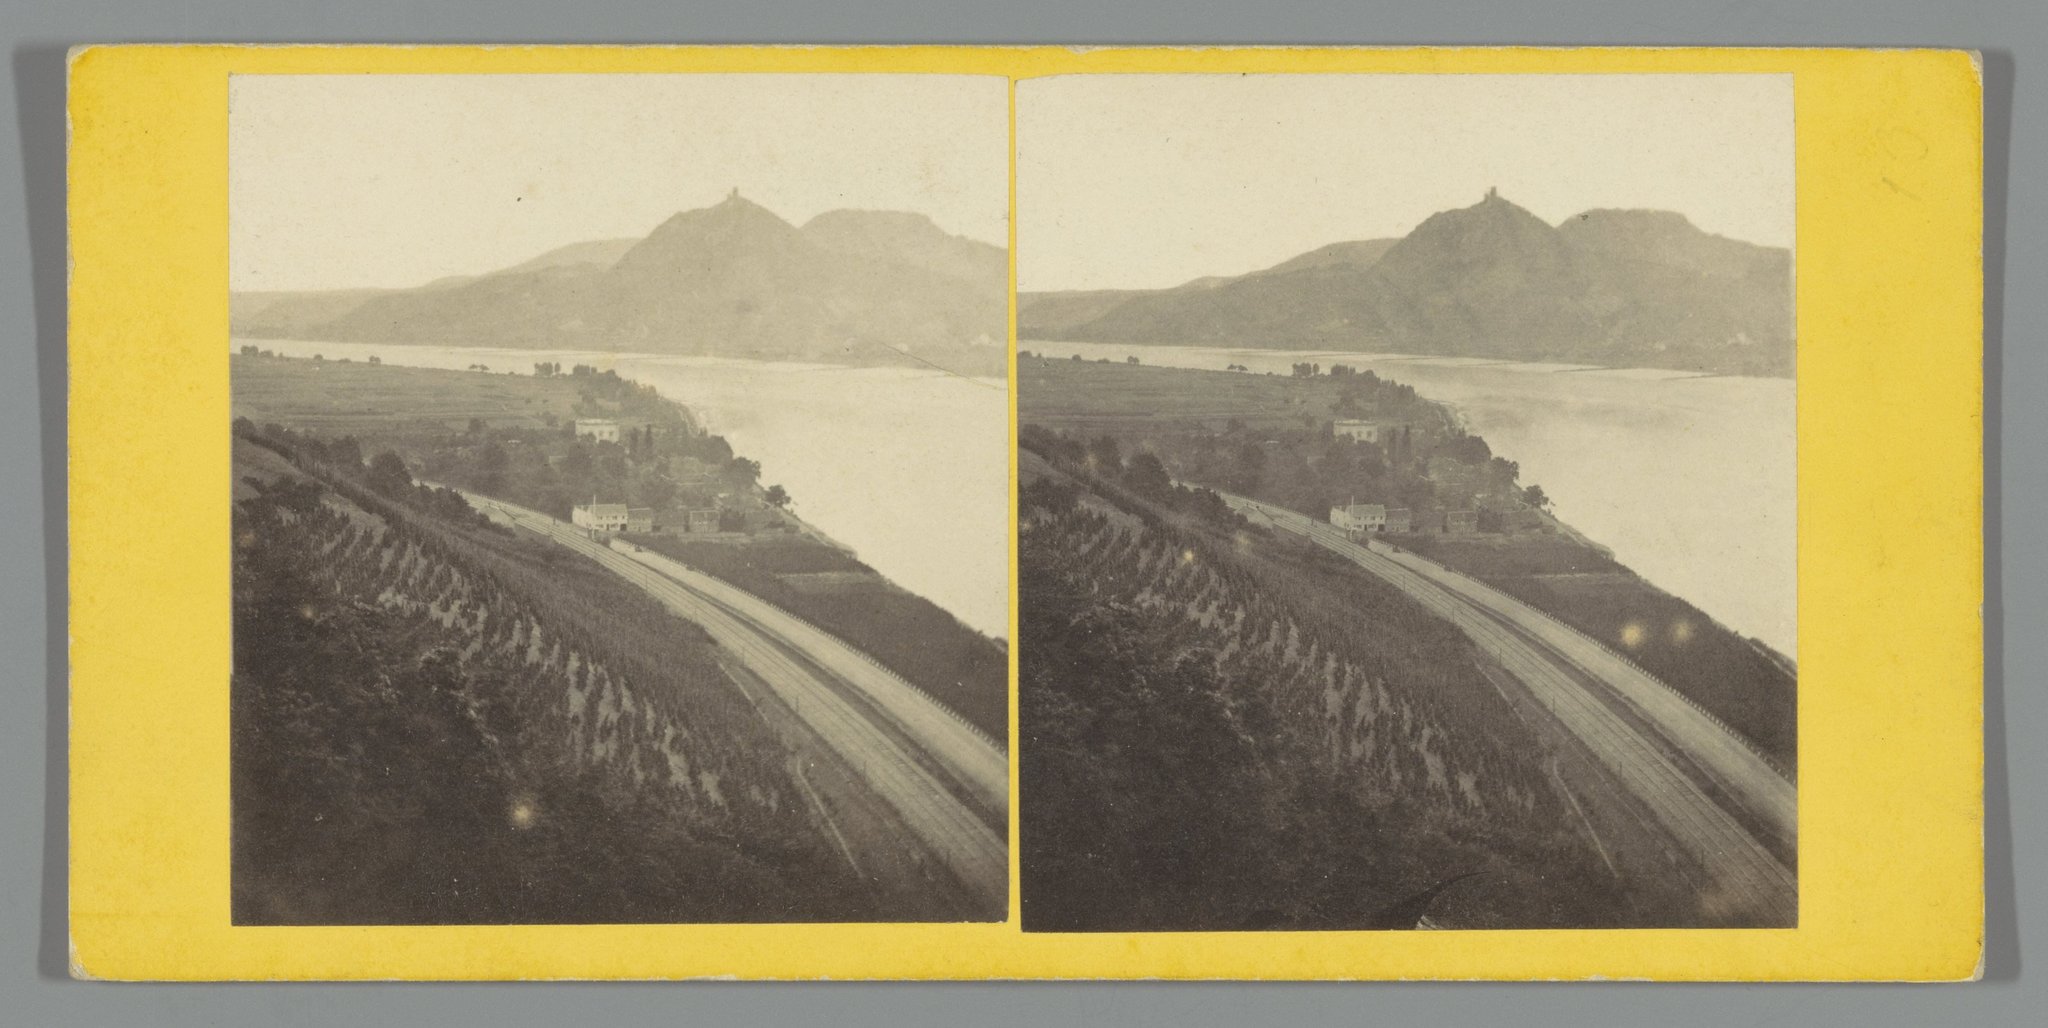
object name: stereograph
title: Gezicht op Rolandseck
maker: Anonymous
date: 1865-1885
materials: cardboard, photographic support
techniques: albumen print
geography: remagen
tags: city-view in general; 'veduta'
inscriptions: inscription: ‘Rolandseck’